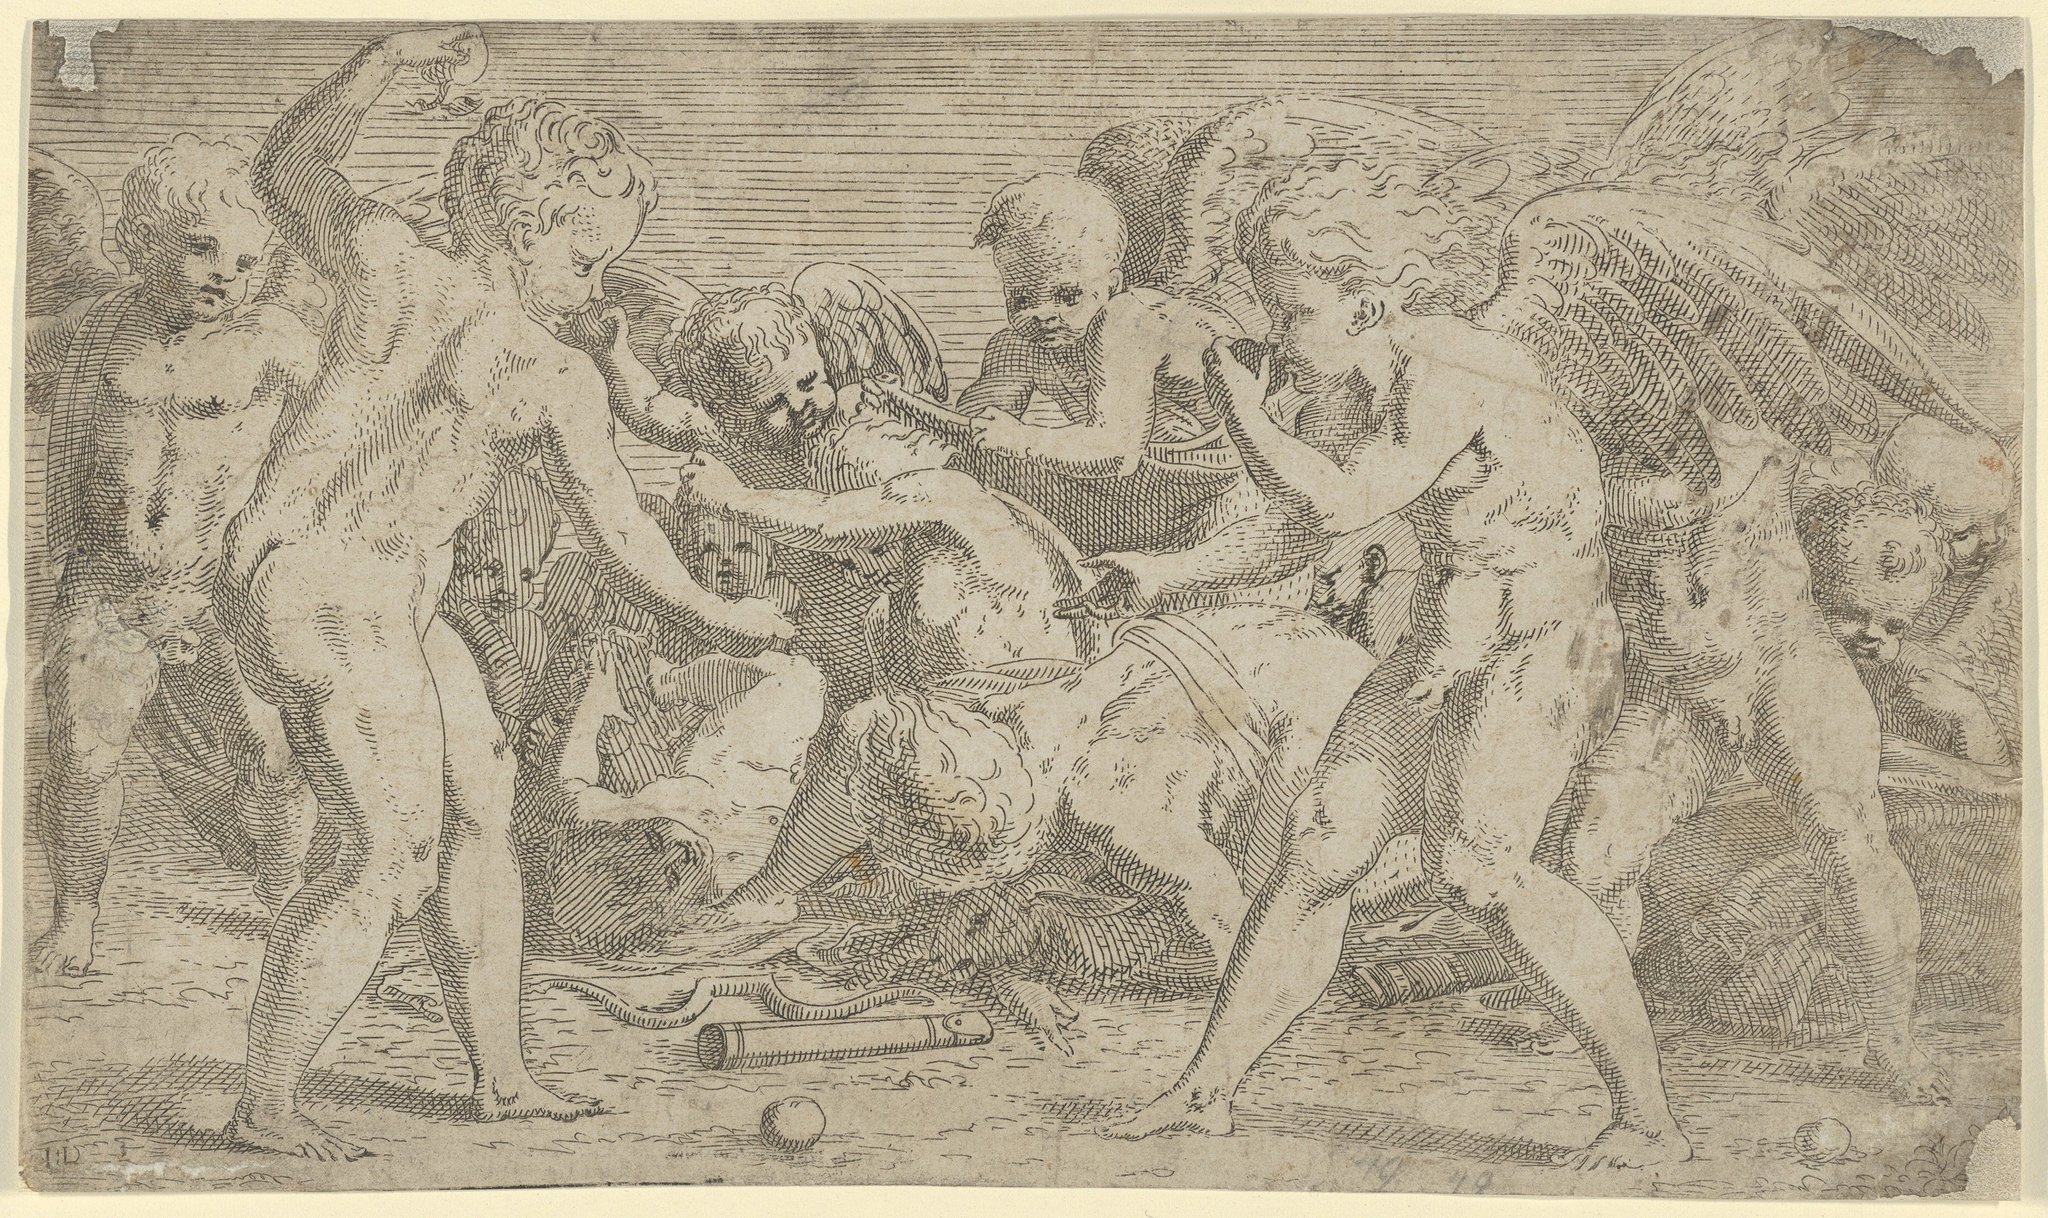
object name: print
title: Putti playing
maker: léon davent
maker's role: artist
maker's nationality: french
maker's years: 1540-1556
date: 1540-1556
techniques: etching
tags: eros